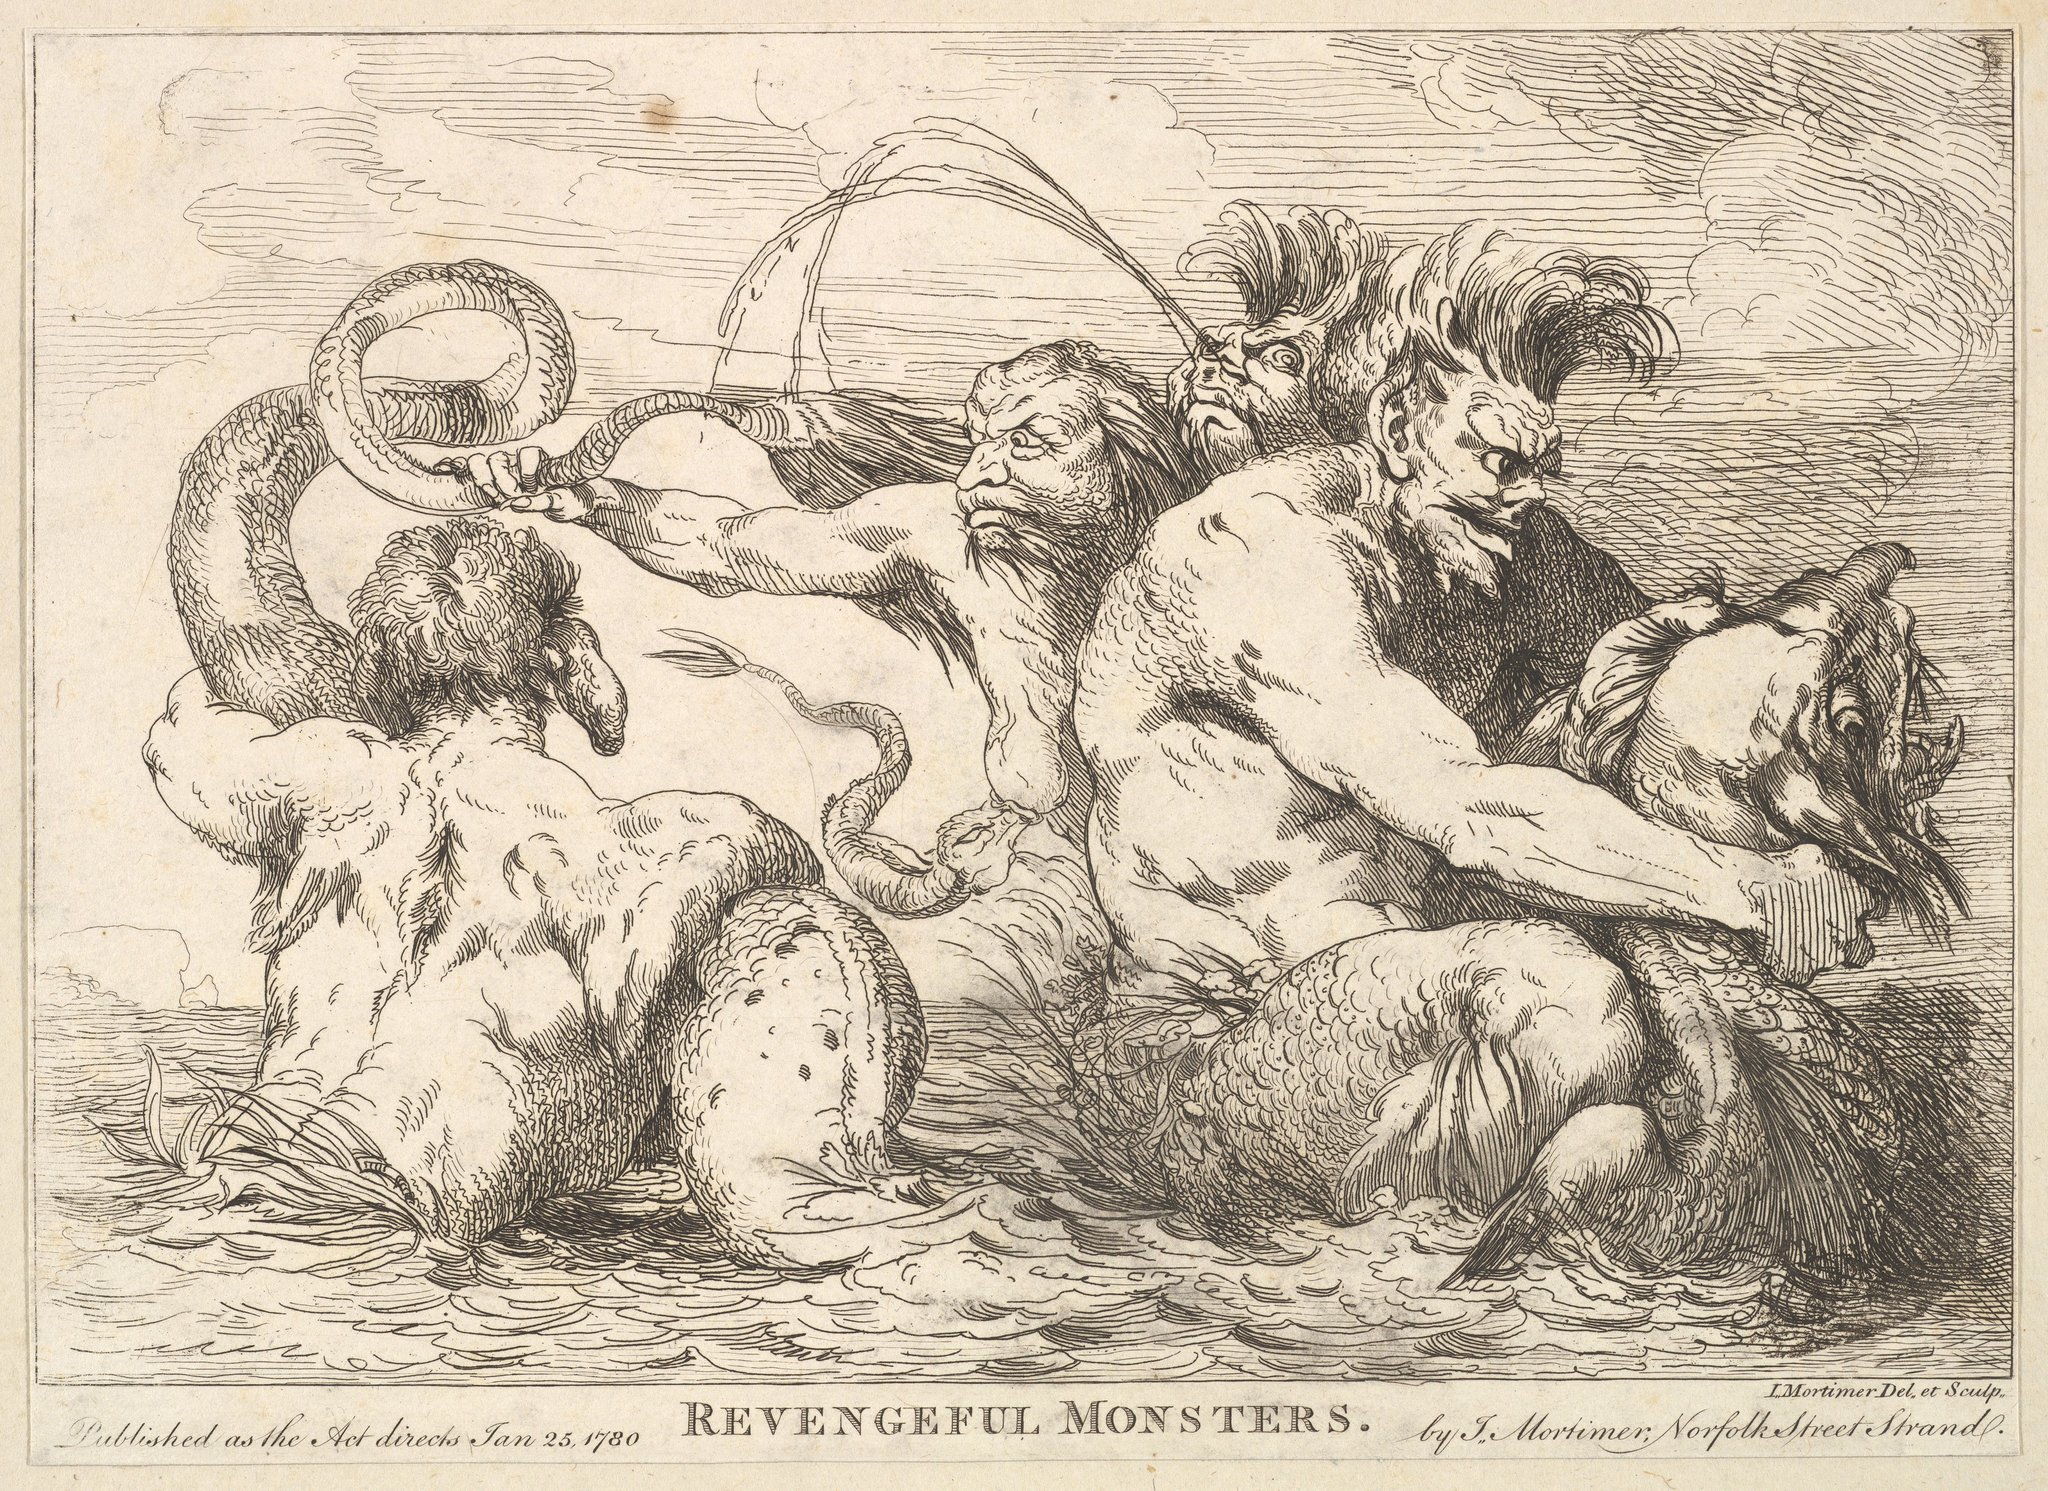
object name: print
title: Revengeful Monsters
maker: john hamilton mortimer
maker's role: artist and publisher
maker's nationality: british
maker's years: 1740-1779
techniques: etching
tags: monsters